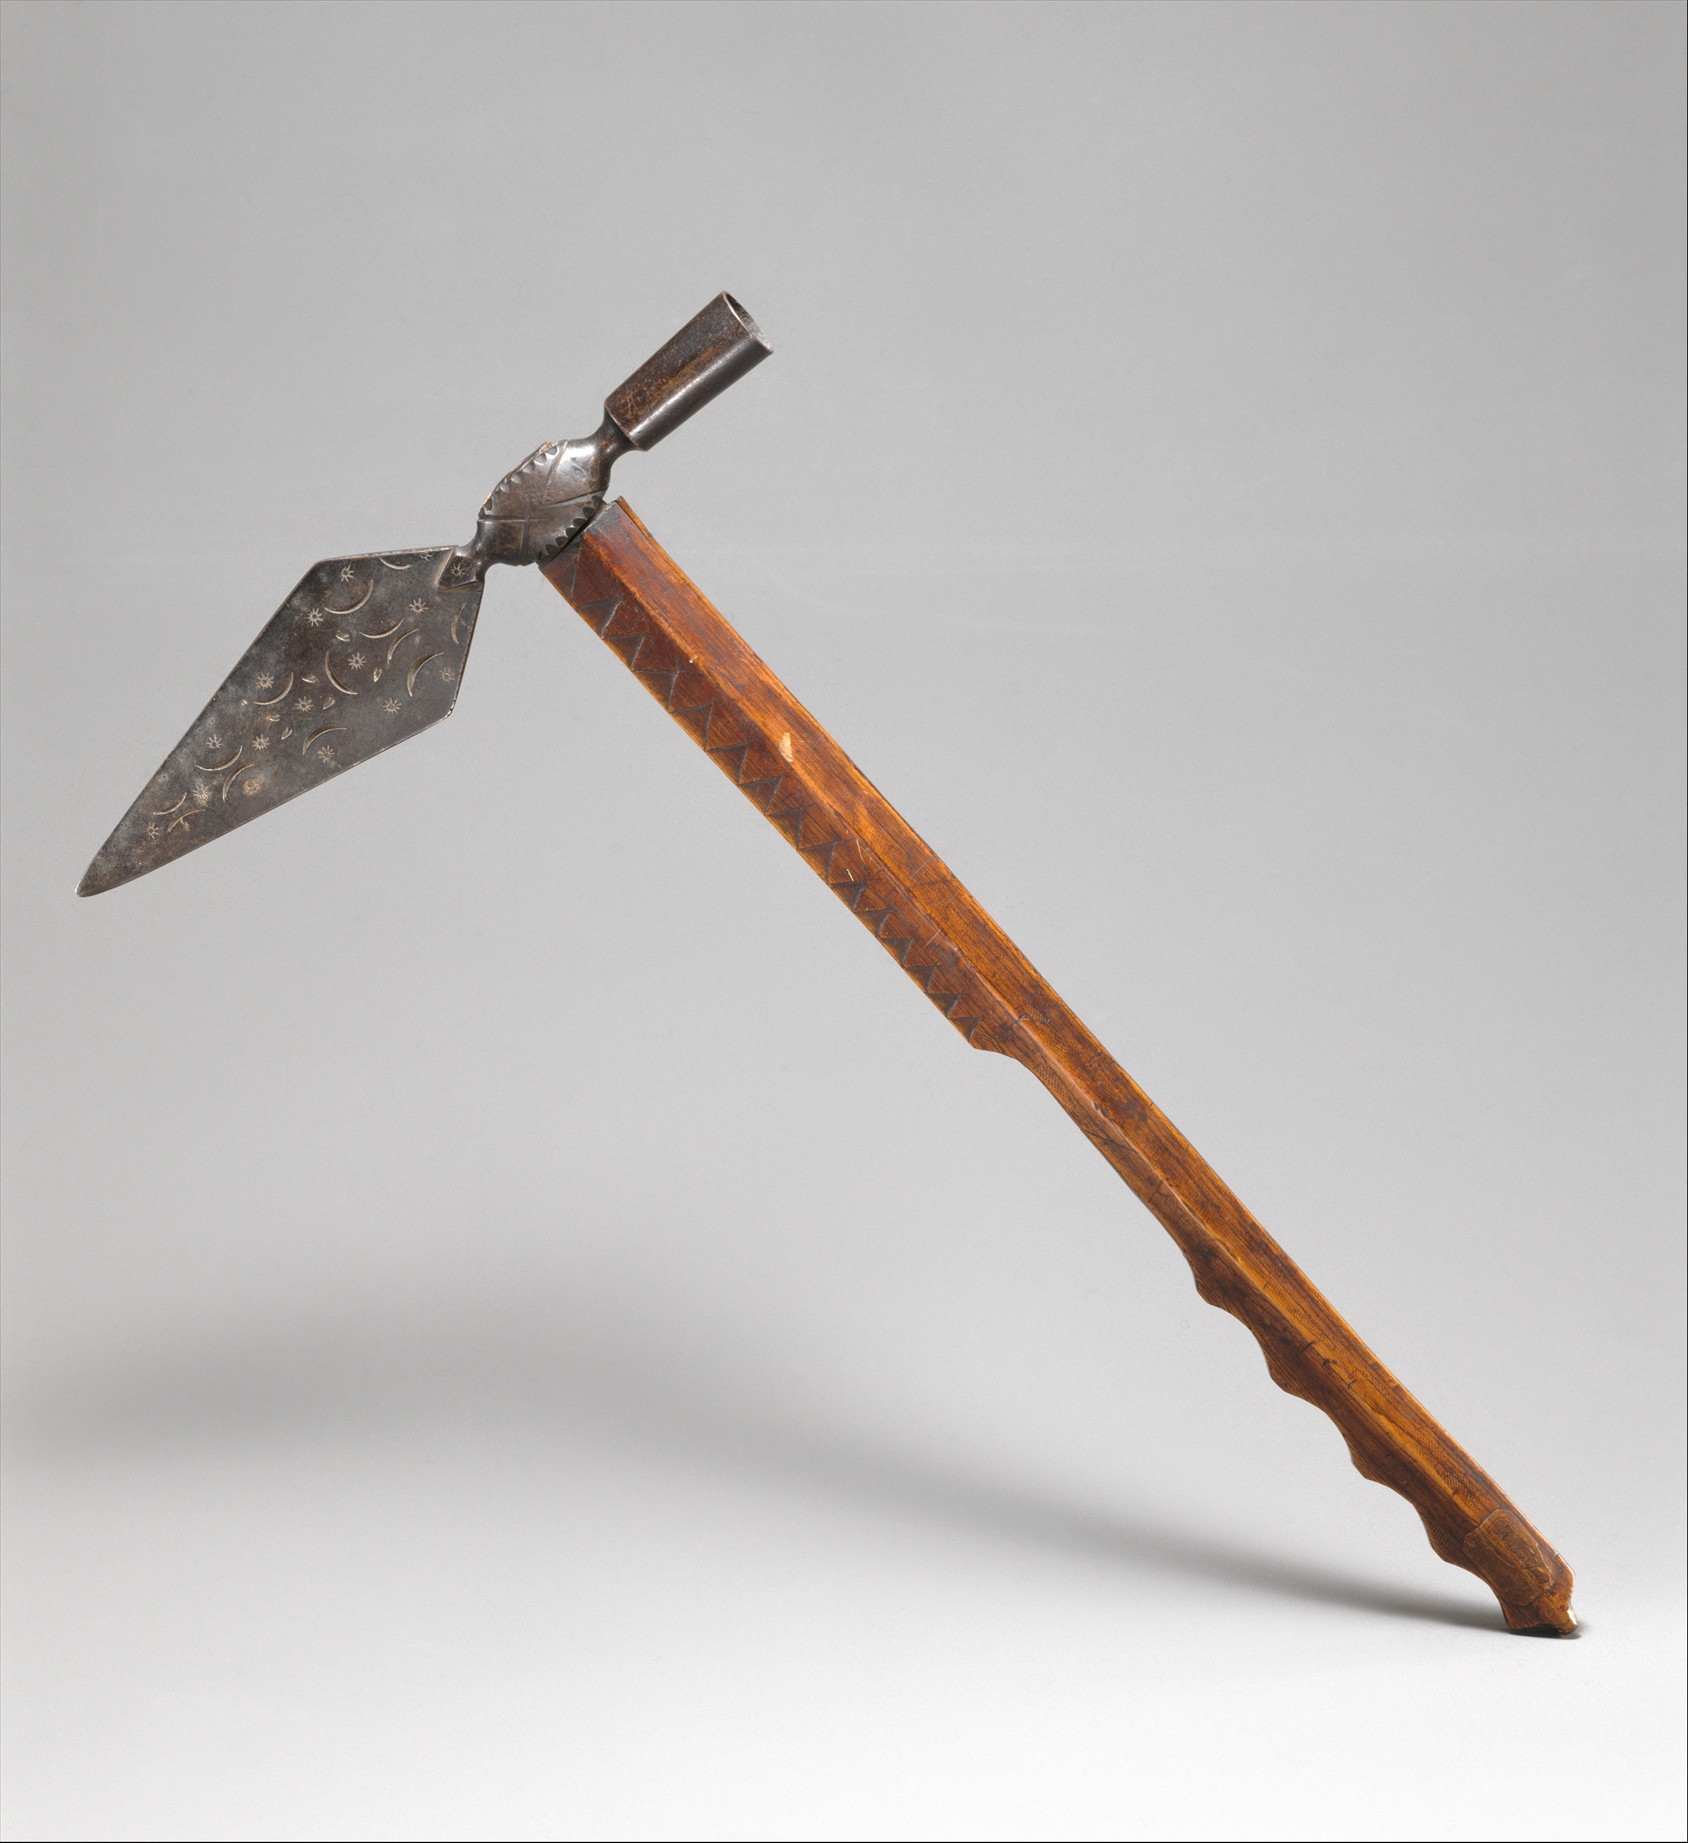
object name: pipe tomahawk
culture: ojibwa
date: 1840-1860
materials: metal, wood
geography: united states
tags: weapons